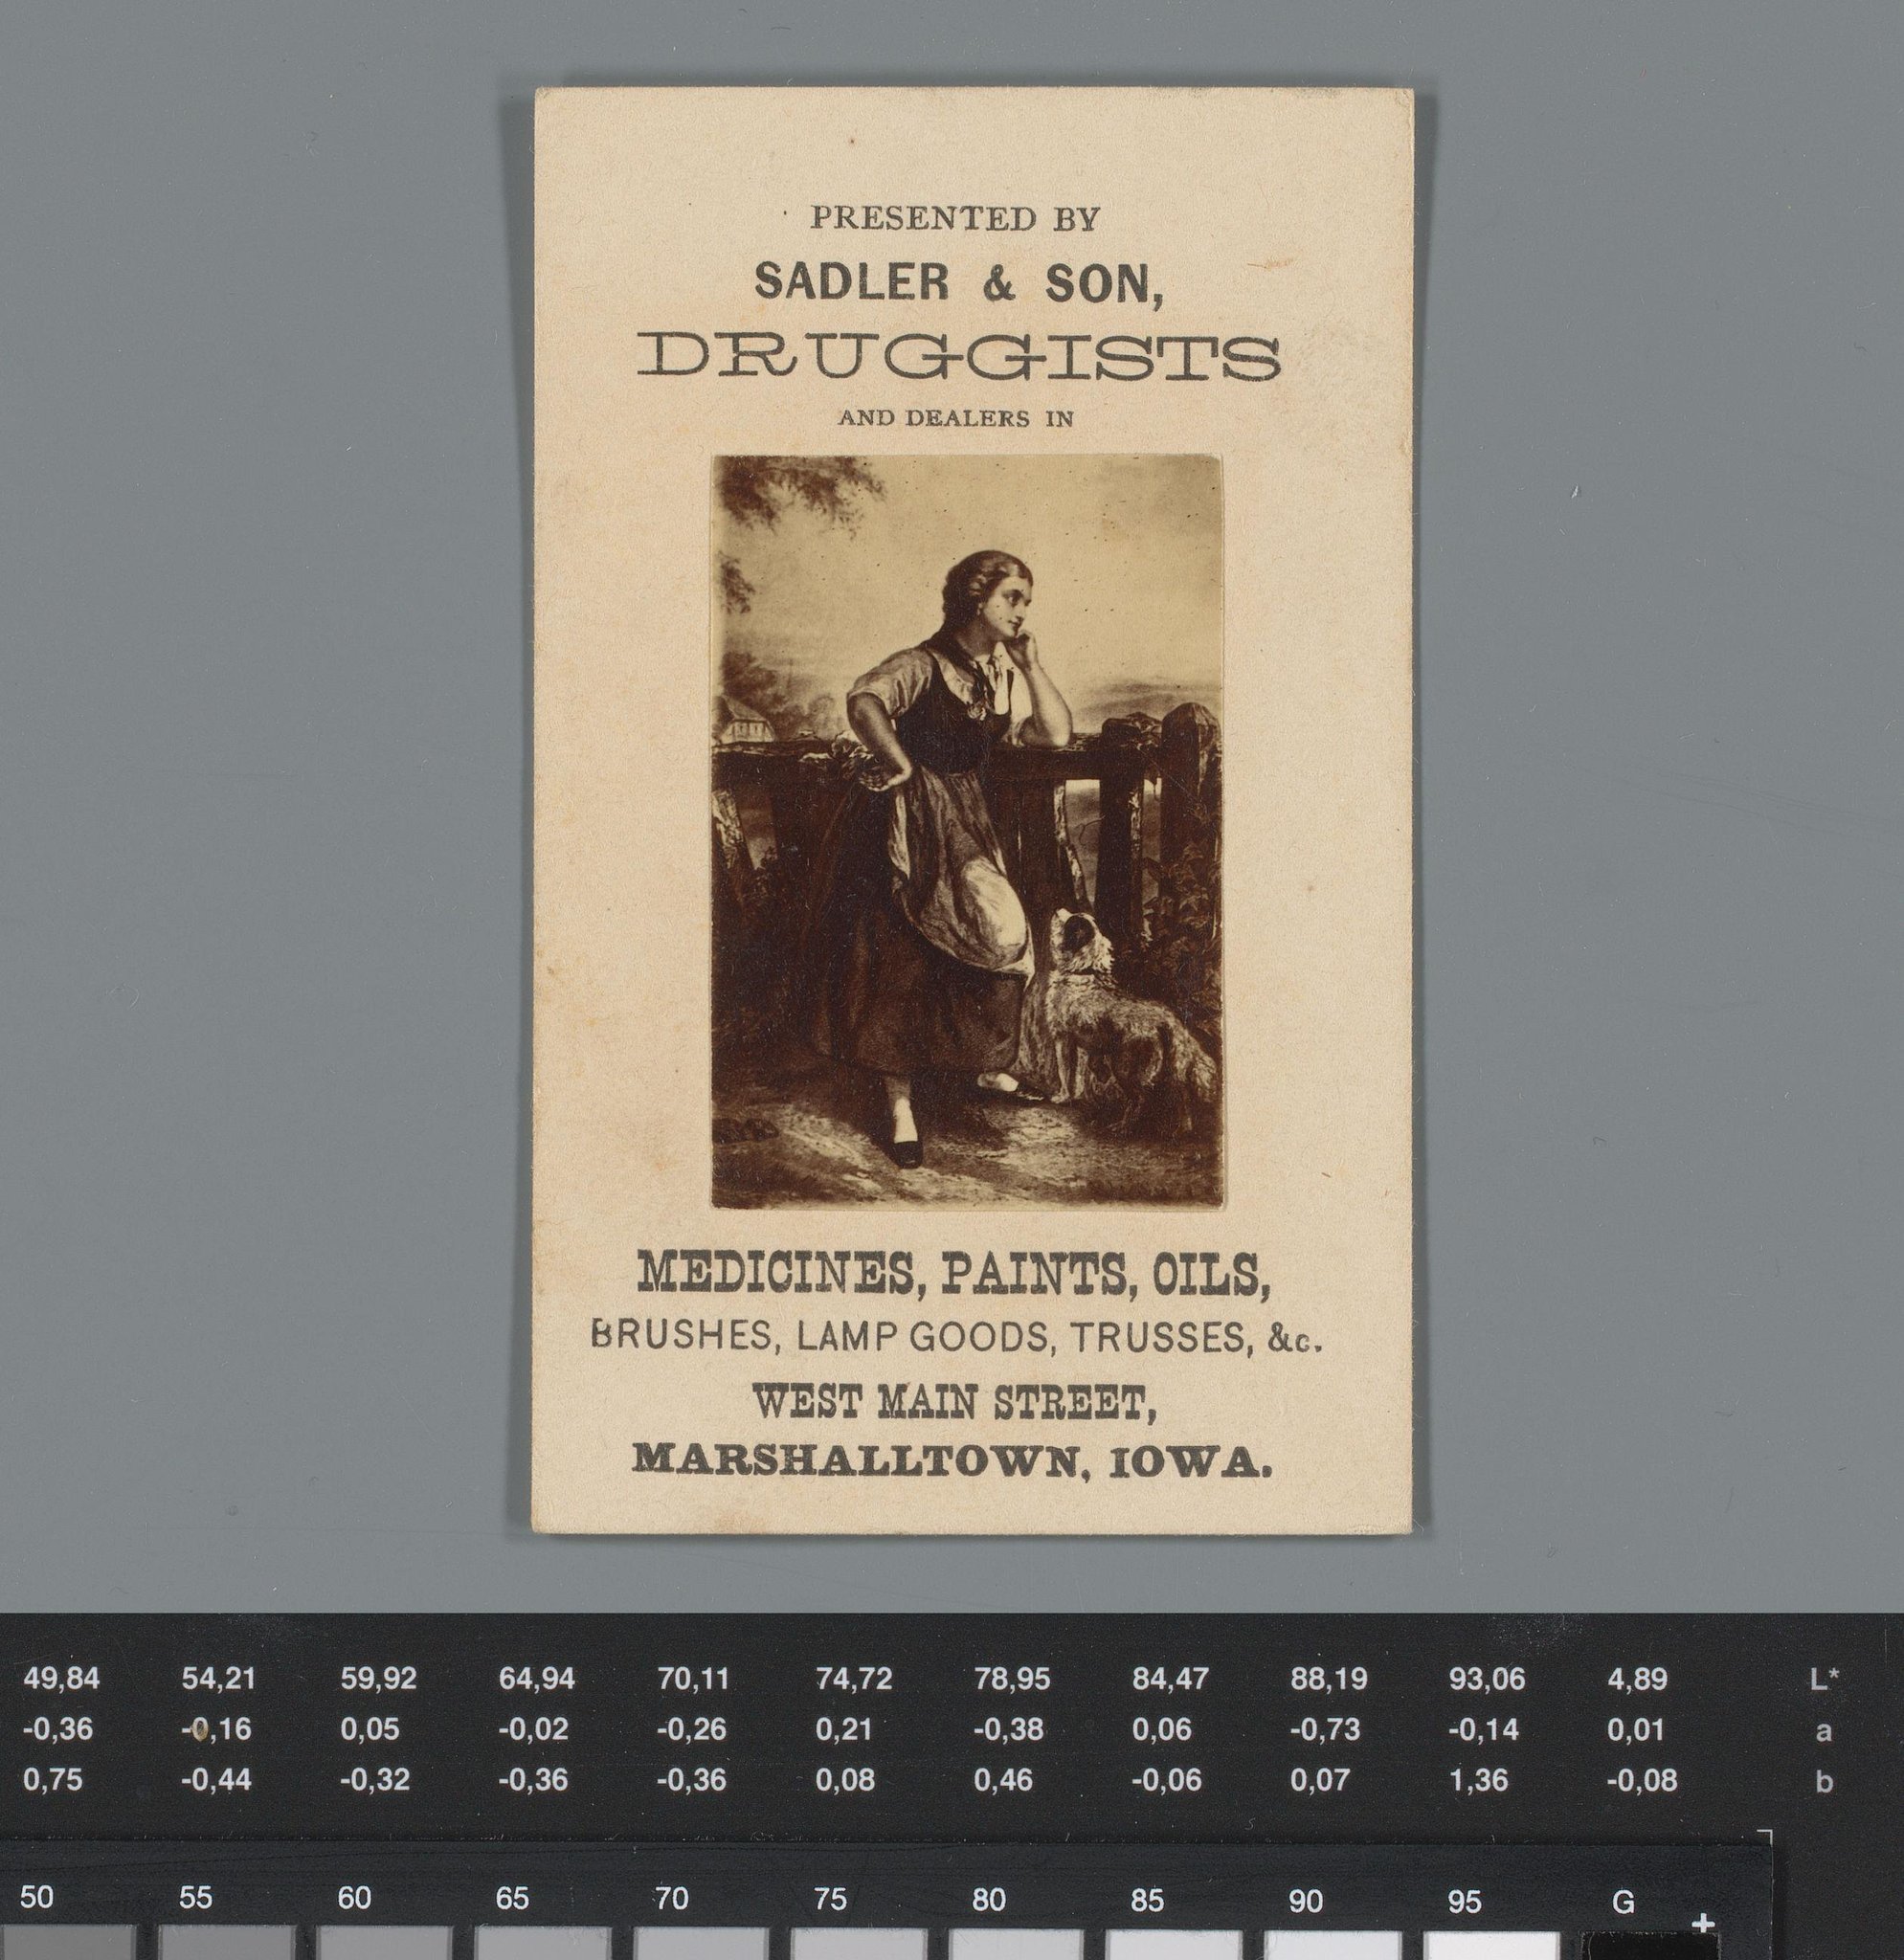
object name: photograph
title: Reclame voor drogisterij Sadler & Son te Marshalltown met reproductie van een prent van een wachtende vrouw met hond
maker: Anonymous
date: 1850-1915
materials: cardboard, photographic support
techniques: albumen print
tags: waiting, watching, adult woman, advertising, dog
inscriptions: inscription: ‘PRESENTED BY / SADLER & SON, / DRUGGISTS / AND DEALERS IN / MEDICINES, PAINTS, OILS (...) MARSHALLTOWN, IOWA.’